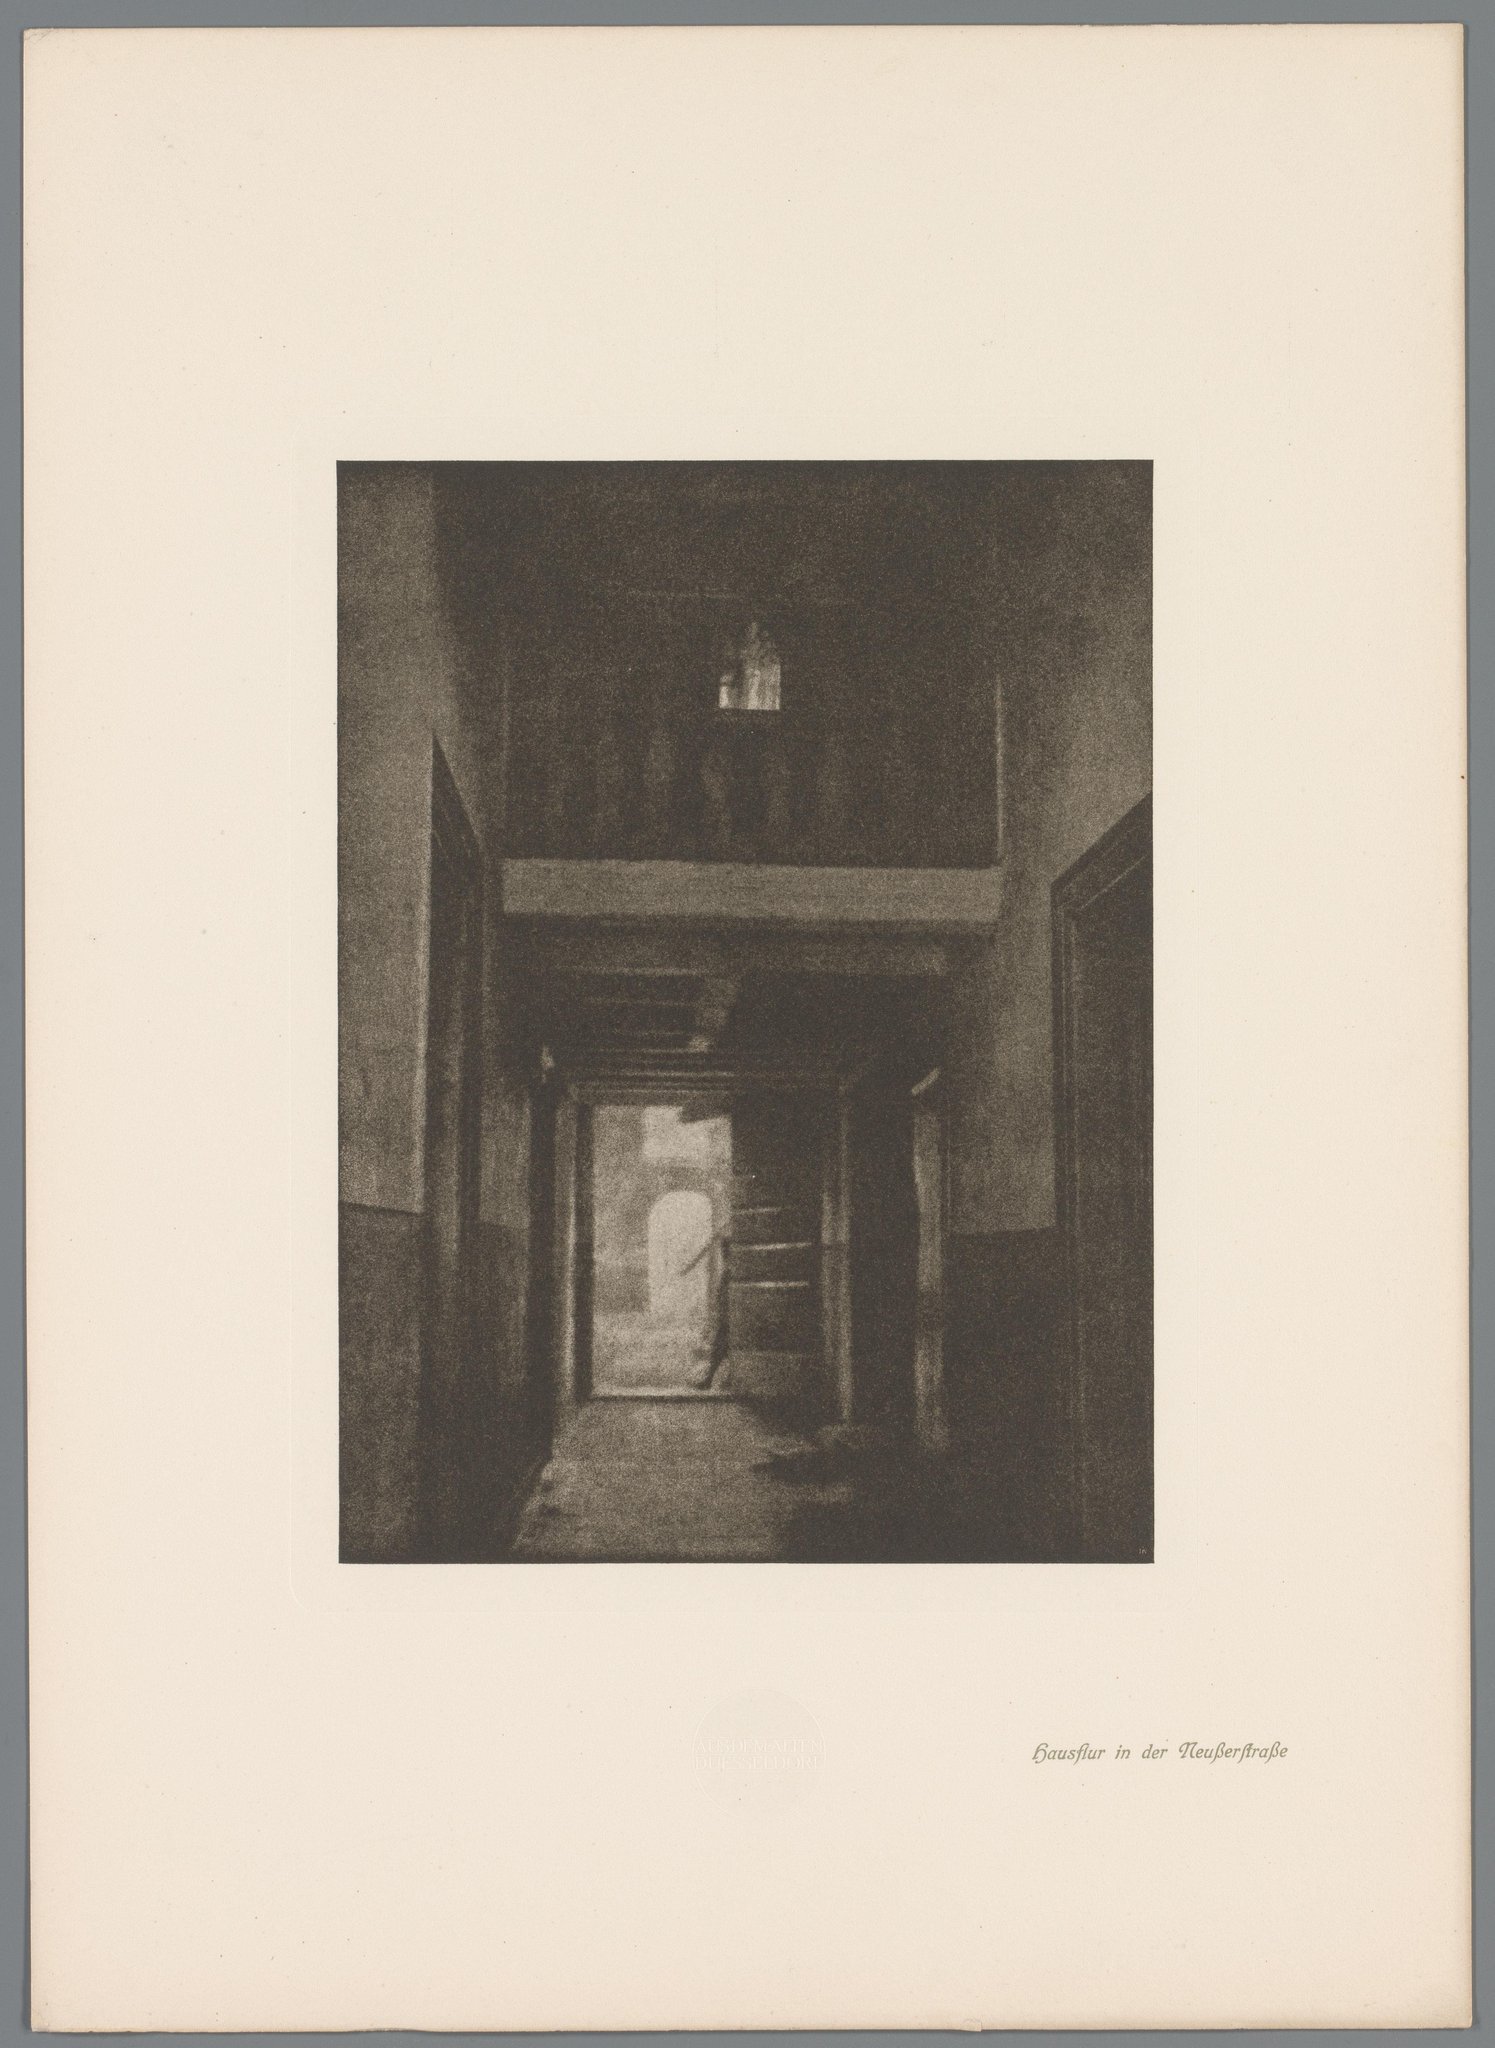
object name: page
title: Reproductie van een gomdruk van het interieur van een woning in de Neusser Straße in Düsseldorf door Erwin Quedenfeldt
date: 1902-1907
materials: paper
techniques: autotype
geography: dusseldorf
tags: urban housing - aa - civic architecture: inside